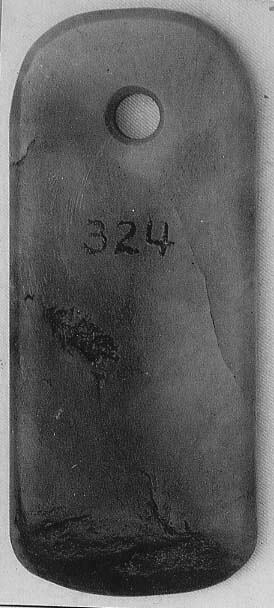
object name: celt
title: Ax Blade Perforated for Use as an Amulet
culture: chinese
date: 206 BCE-220 CE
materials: jade